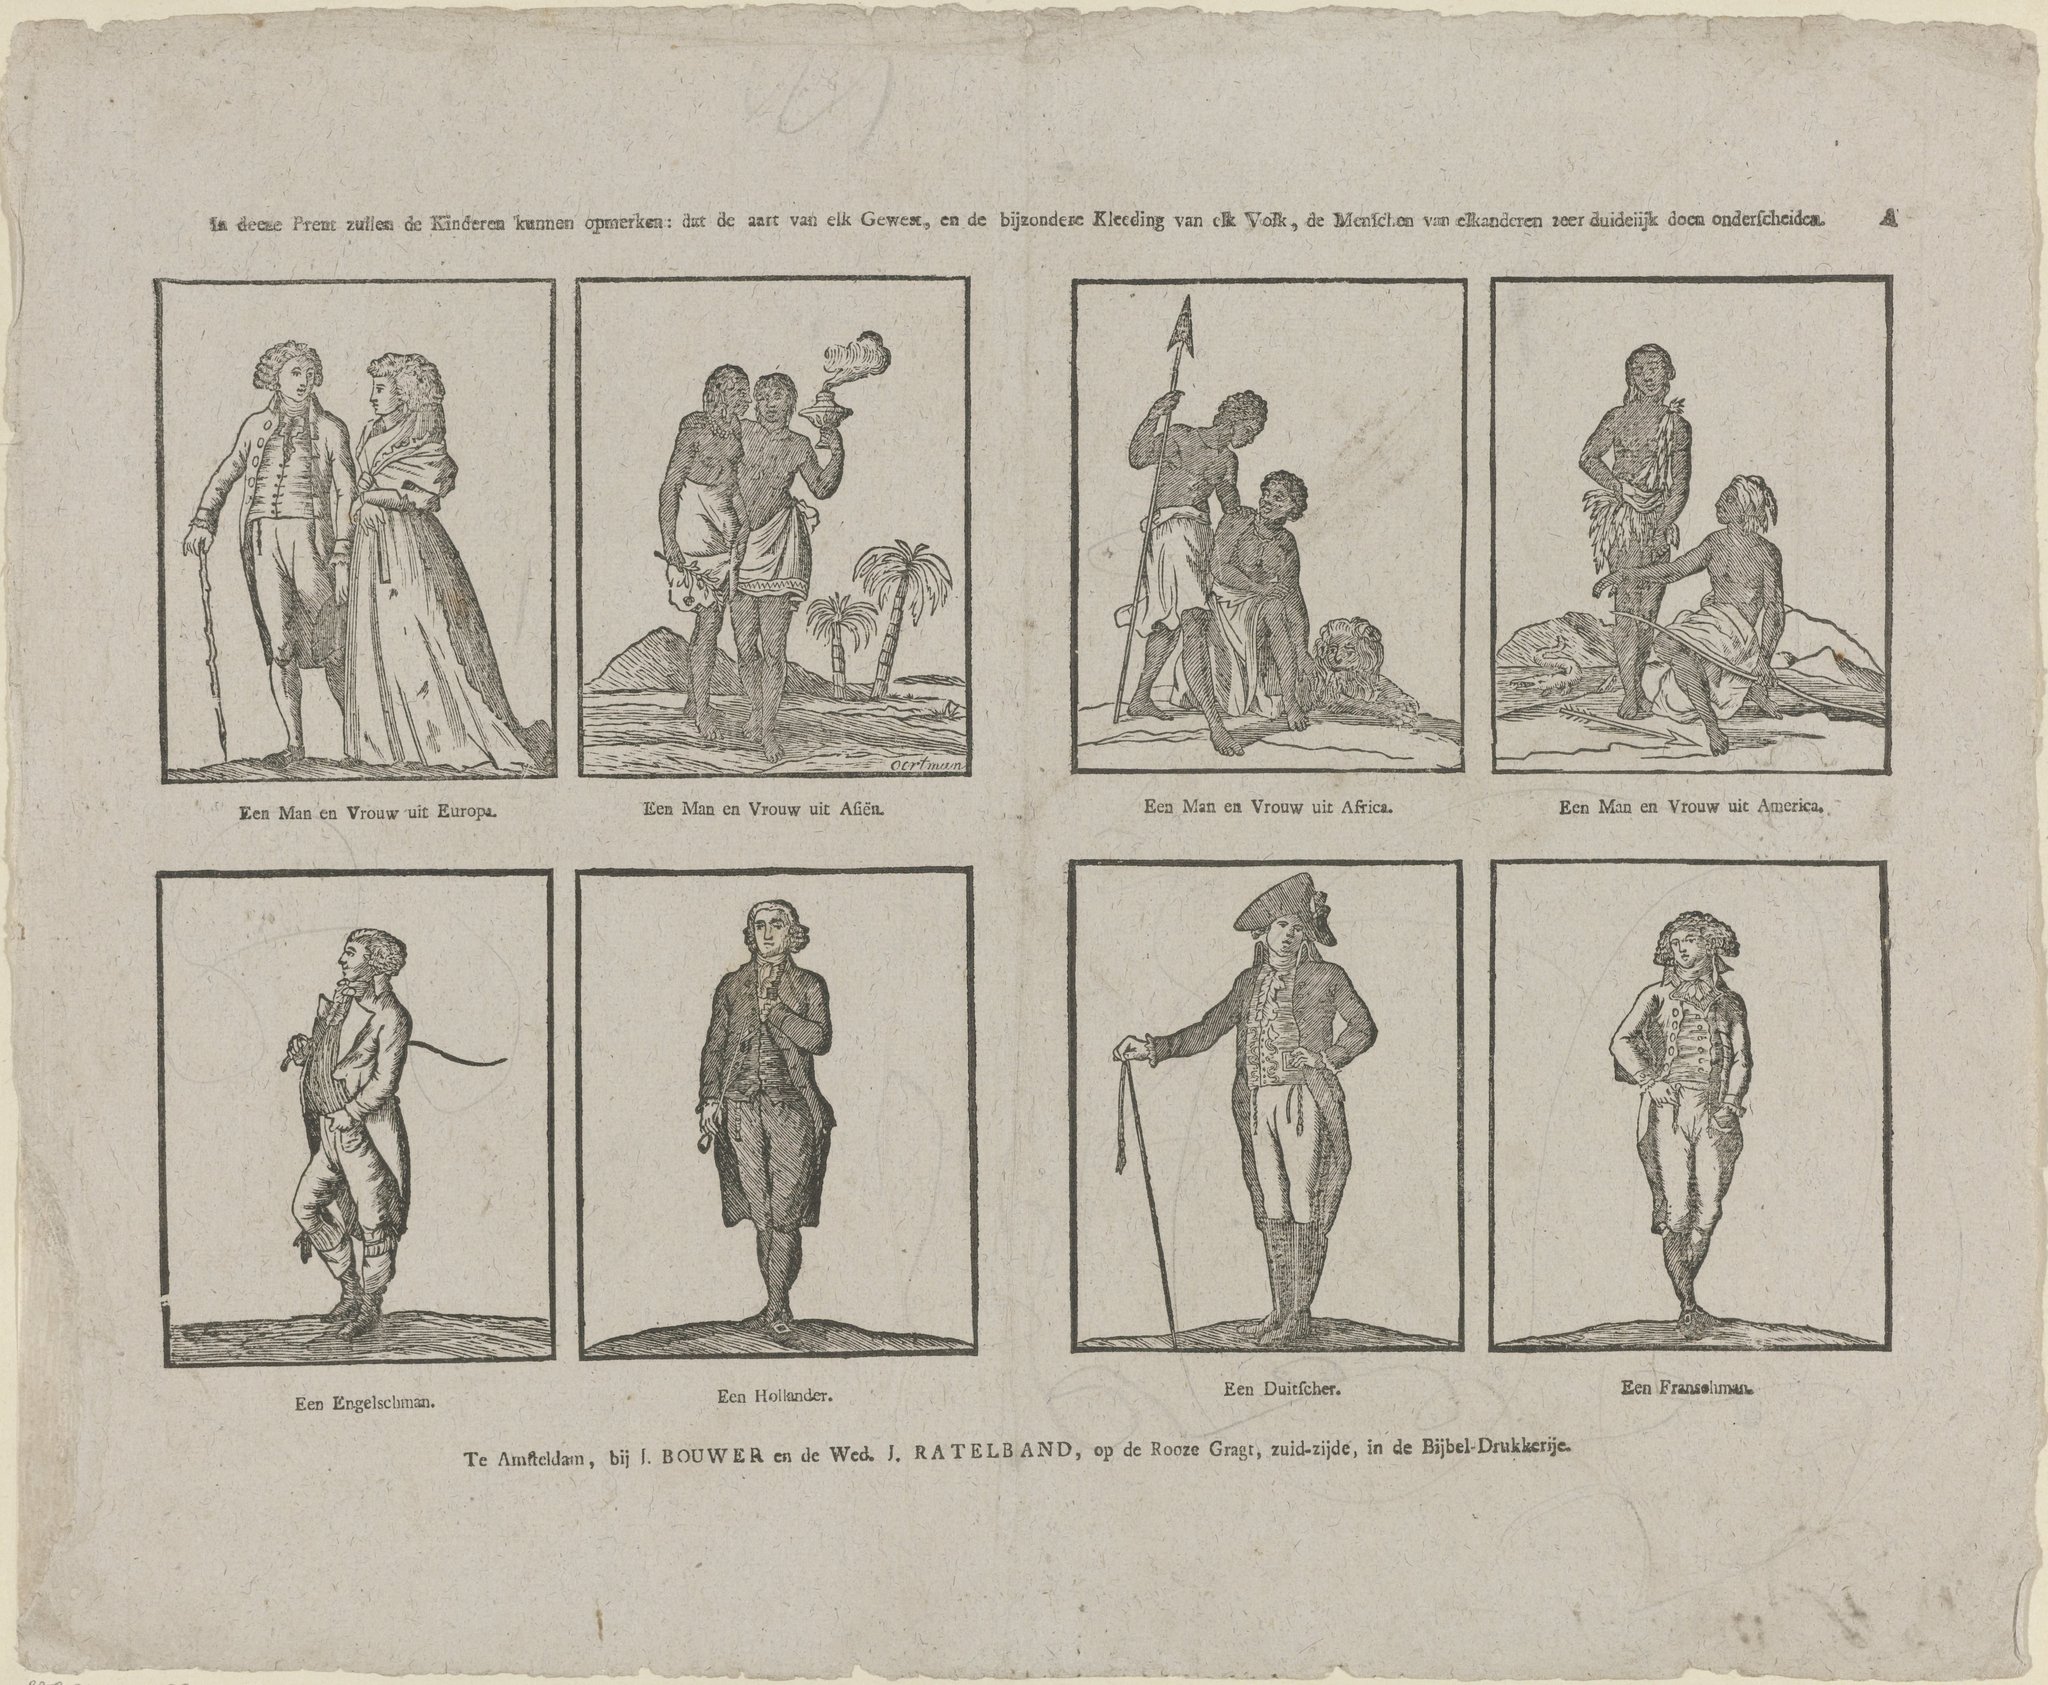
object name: print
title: In deeze prent zullen de kinderen kunnen opmerken: dat de aart van elk gewest, en de bijzondere kleeding van elk volk, de menschen van elkanderen zeer duidelijk doen onderscheiden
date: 1794-1804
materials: paper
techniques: letterpress printing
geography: amsterdam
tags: folk costume, regional costume, clothes, costume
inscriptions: collector's mark: Lugt 2760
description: Blad met 8 voorstellingen van de kleding van verschillende nationaliteiten en volkeren. Onder elke afbeelding een onderschrift. Genummerd rechtsboven: A.